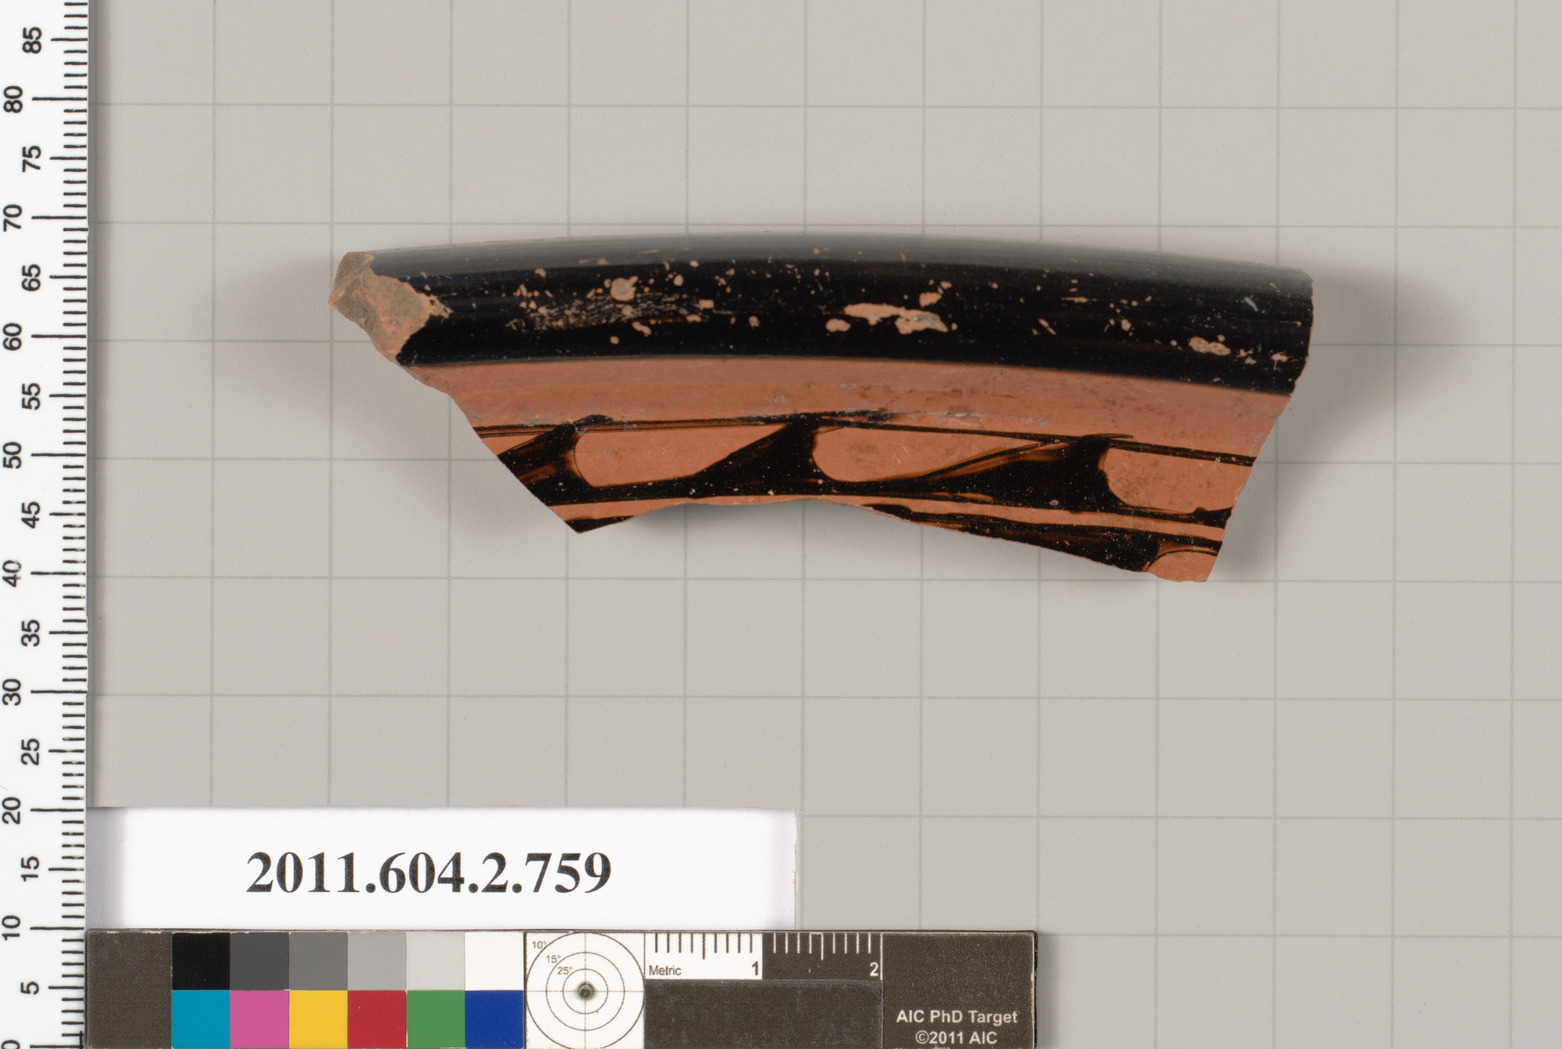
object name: calyx krater fragment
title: Terracotta fragment of a calyx-krater (bowl for mixing wine and water)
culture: greek, attic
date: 475-451 BCE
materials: terracotta